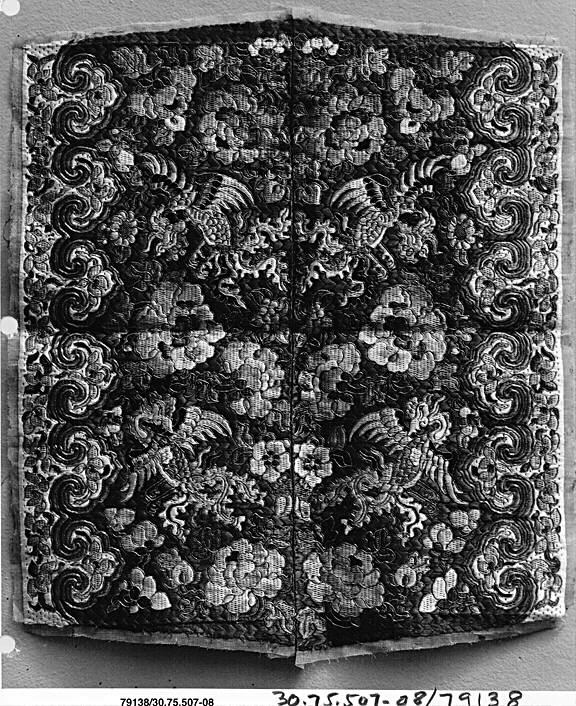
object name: panel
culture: chinese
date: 1801-1900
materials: metal thread, silk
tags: birds,flowers